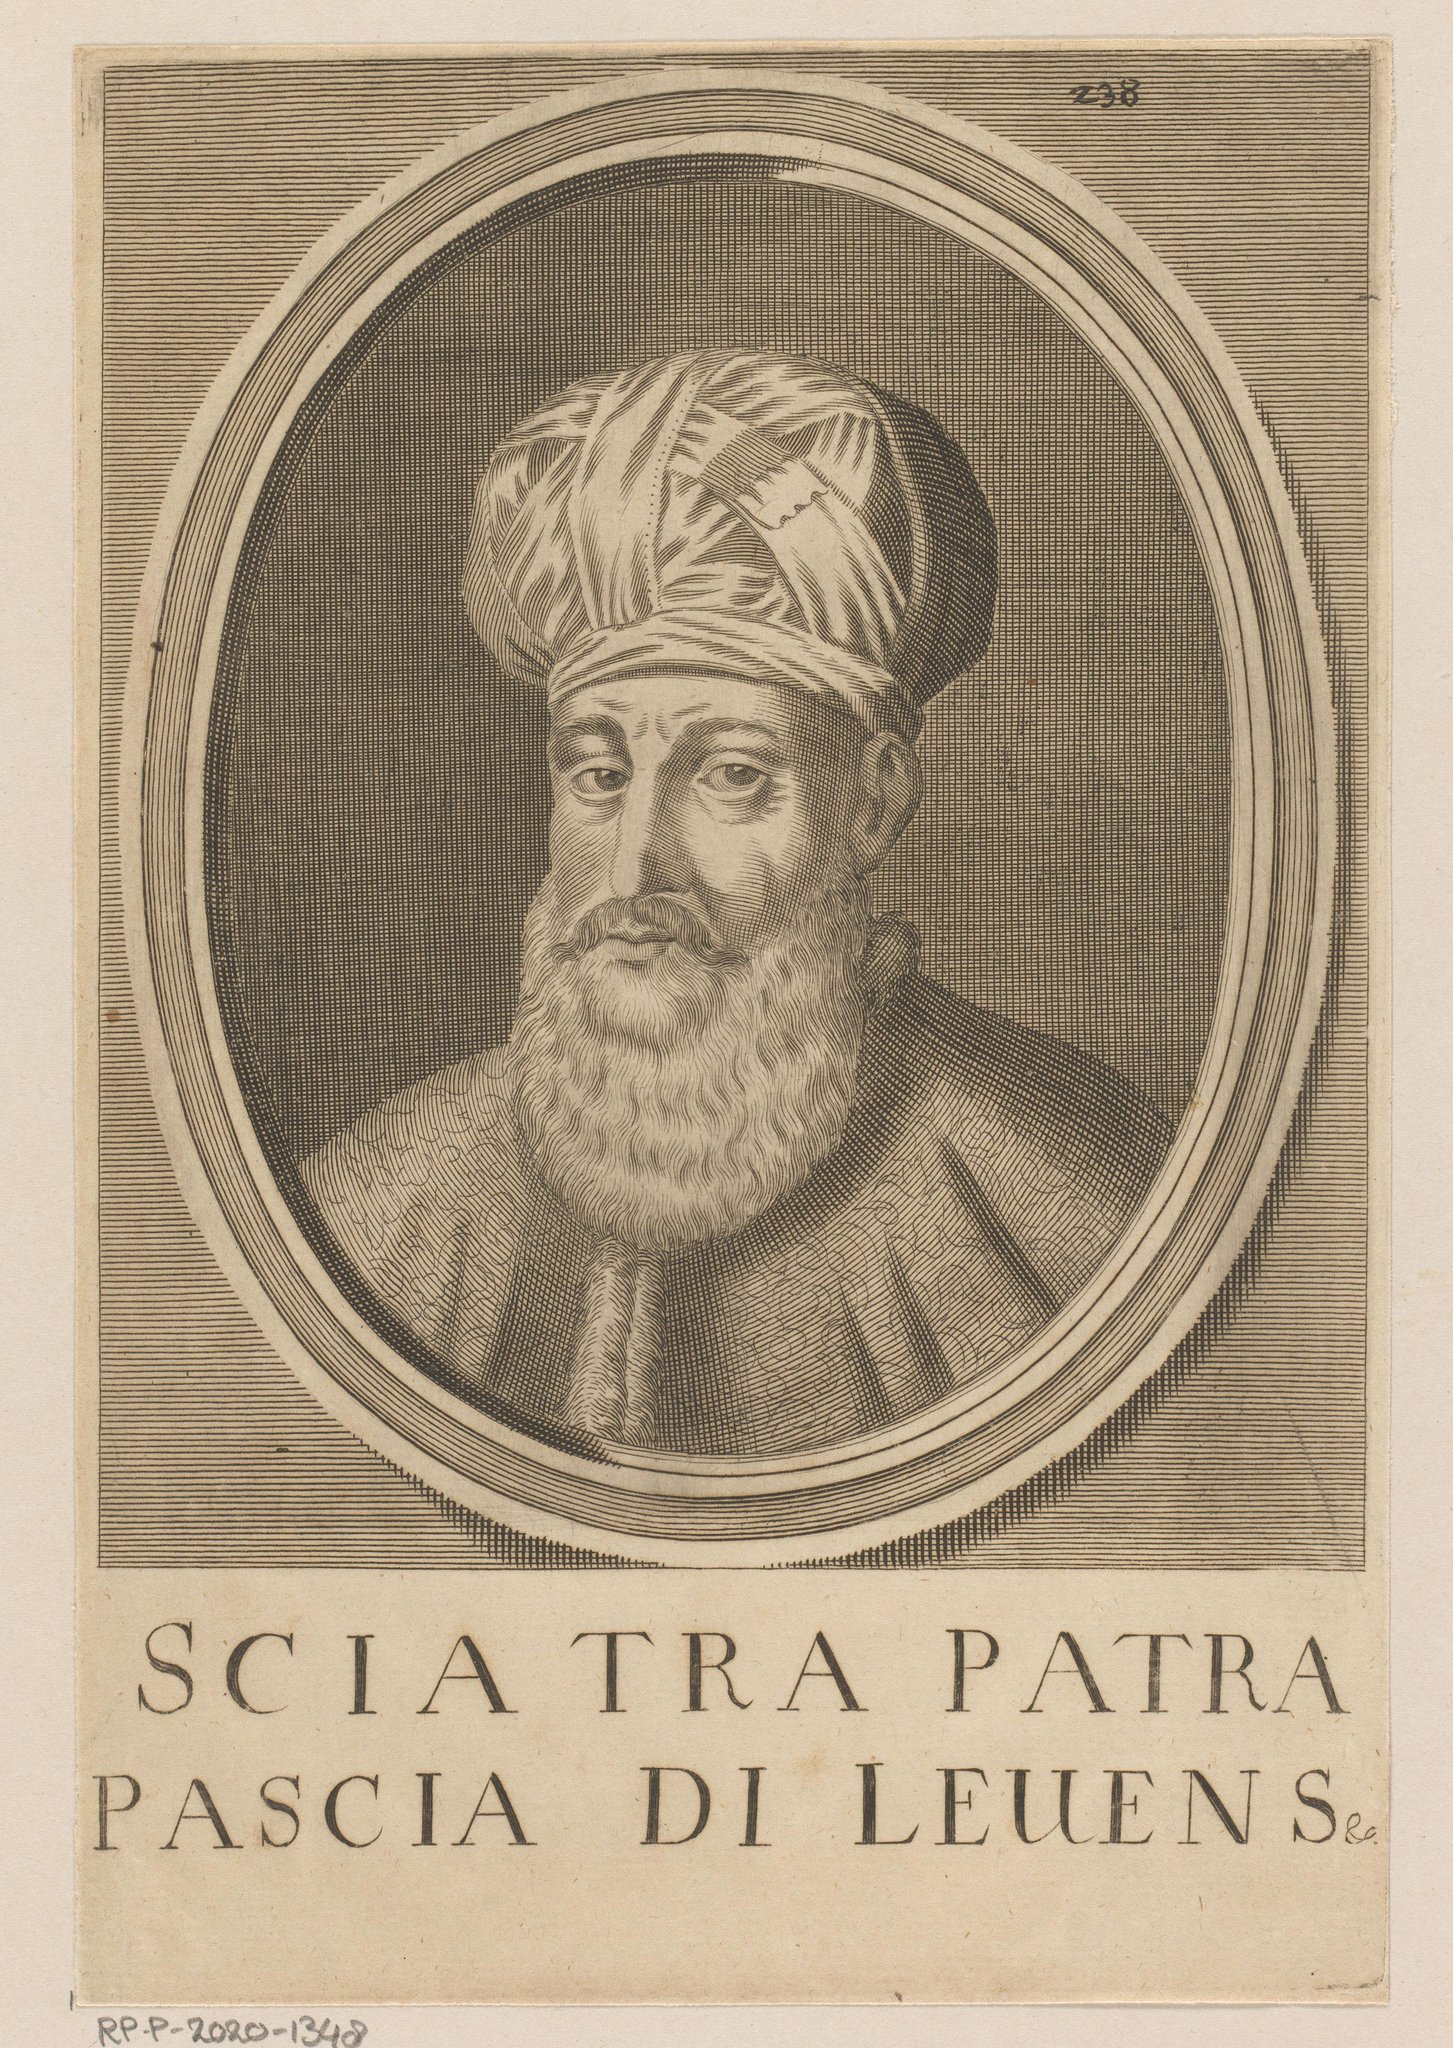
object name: print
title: Portret van een onbekende pasja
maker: Anonymous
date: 1670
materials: paper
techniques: engraving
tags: historical persons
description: Prent gebruikt in: Priorato, Galeazzo Gualdo. Historia Di Leopoldo Cesare (...). 4 dln. Wenen: Giovanni Battista Hacque, 1670, dl. 2.